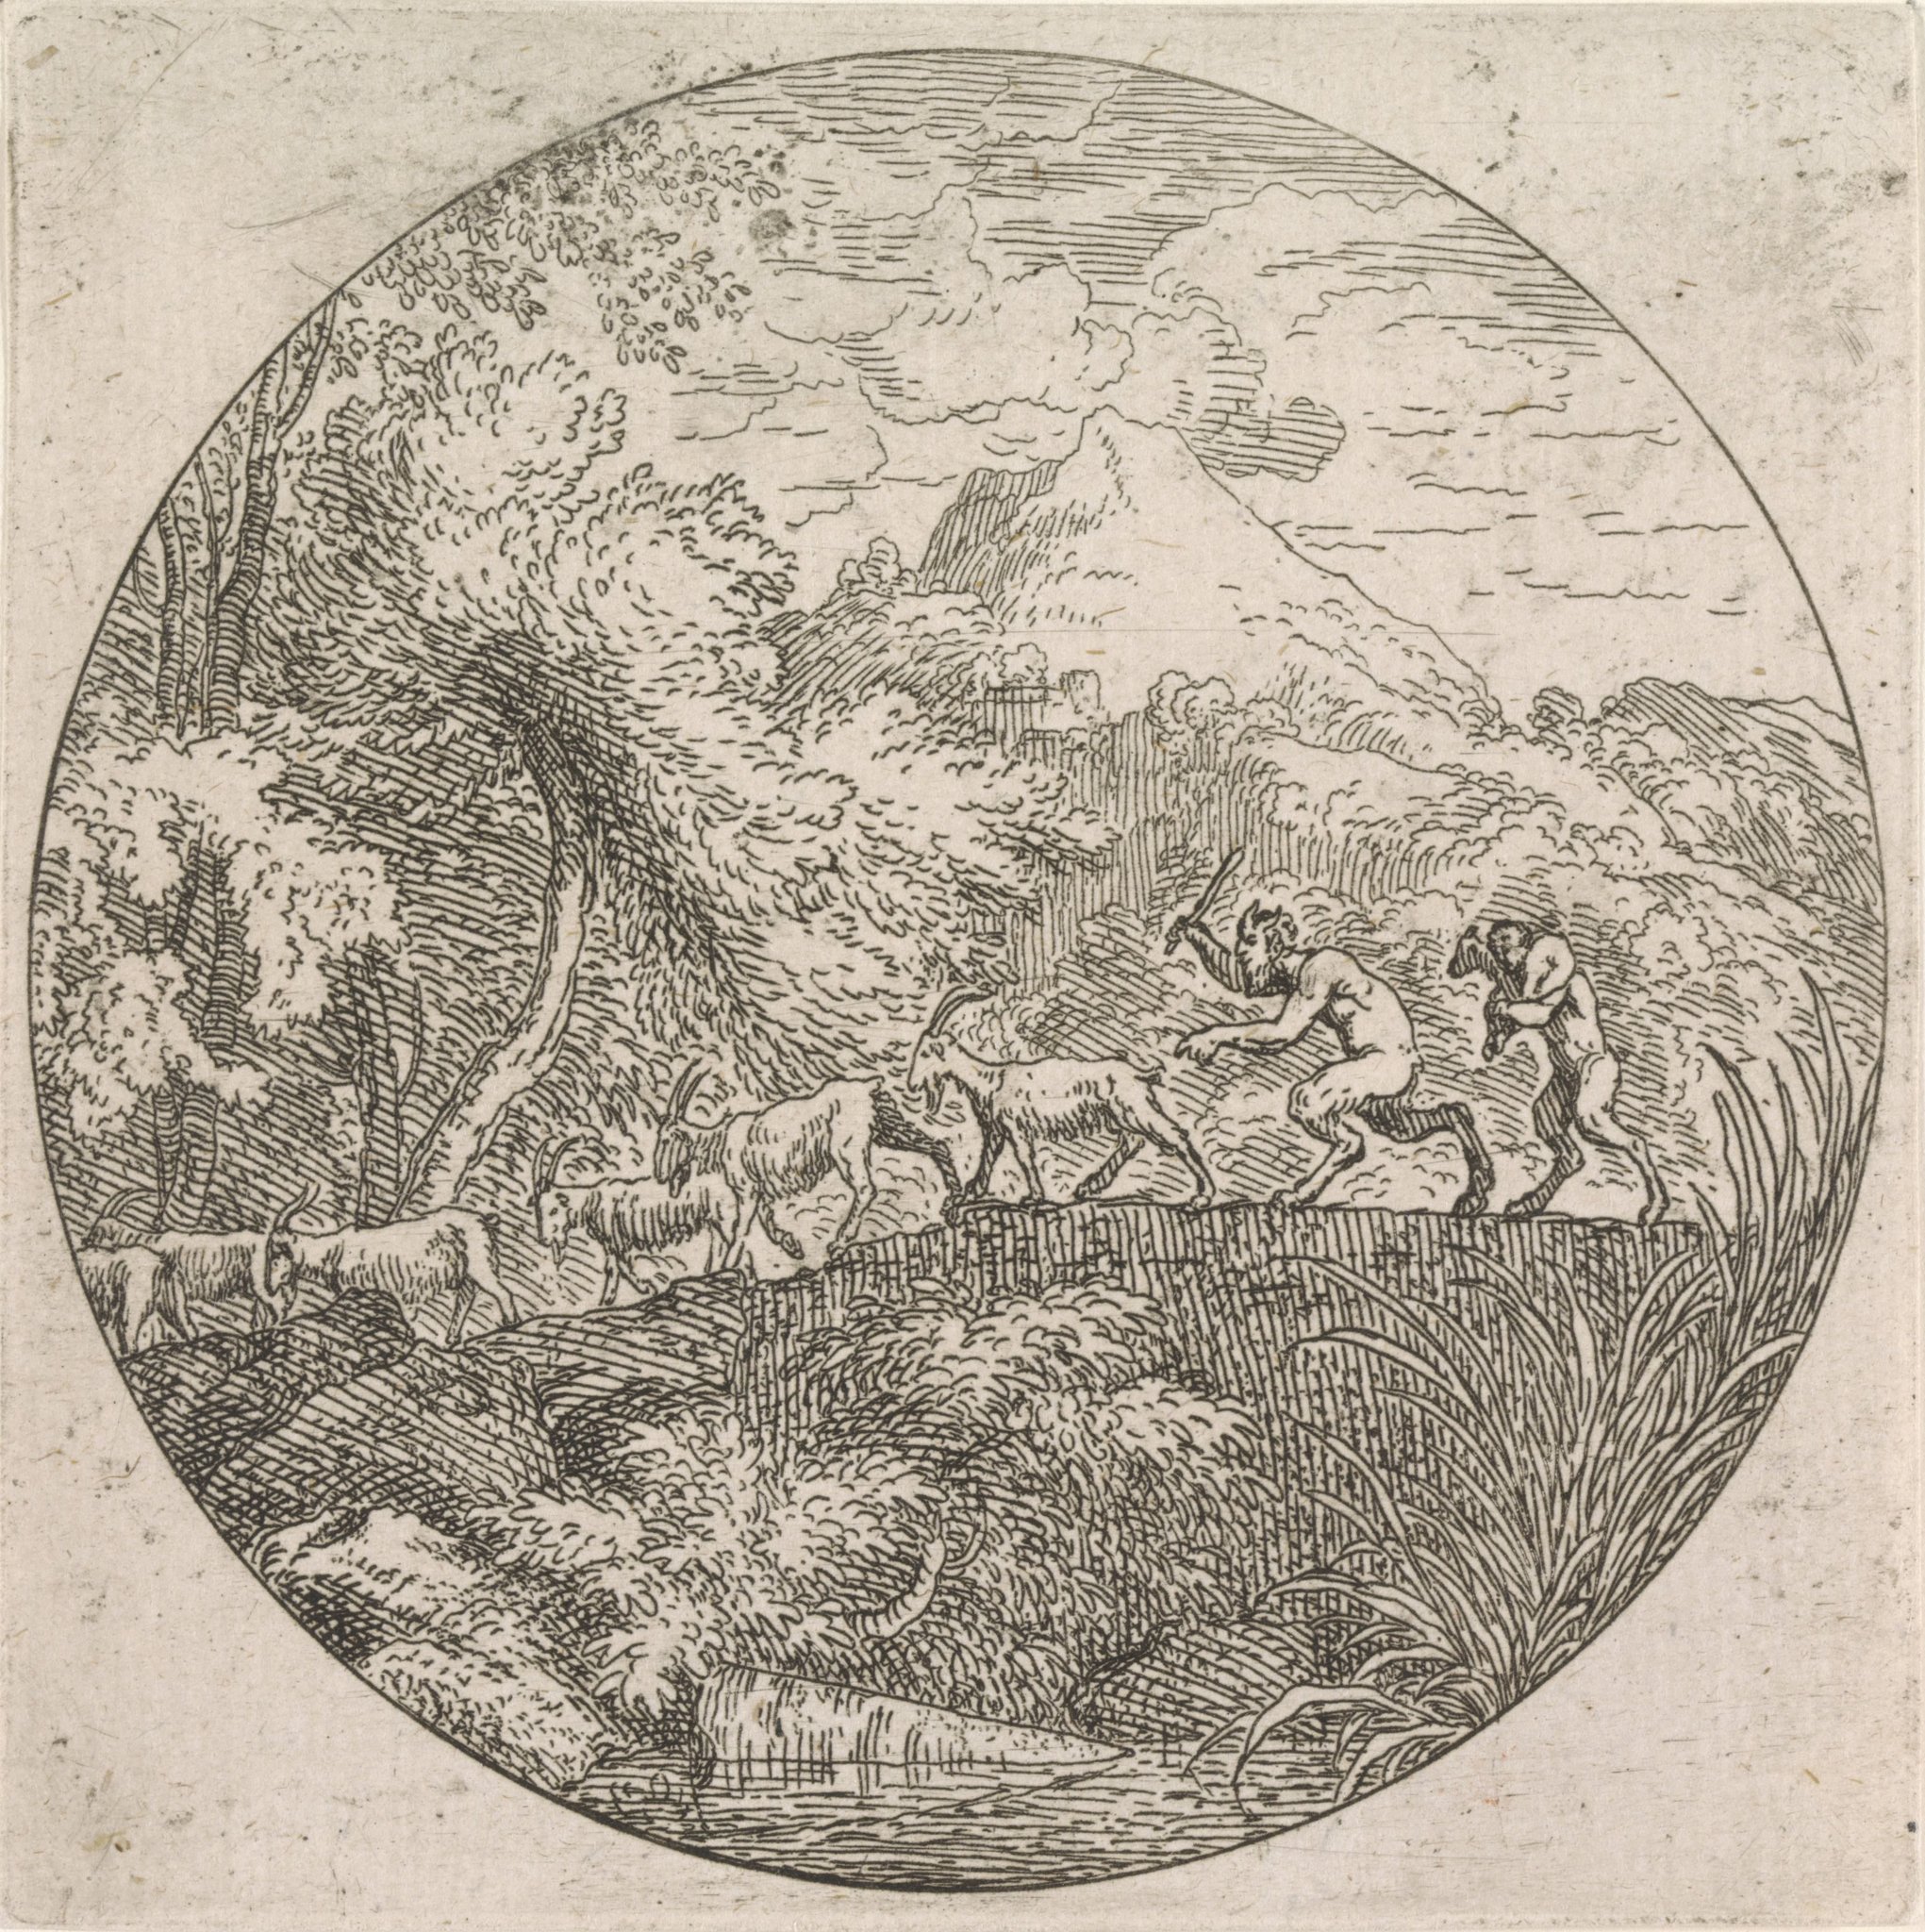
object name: print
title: Twee saters met een kudde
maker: abraham genoels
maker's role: draughtsman, print maker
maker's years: 1640-1723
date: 1650-1724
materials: paper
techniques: etching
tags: satyr(s) (in general), goat, mountains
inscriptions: collector's mark: Lugt 240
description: Twee staters. Ze drijven in een berglandschap een kudde geiten voort.